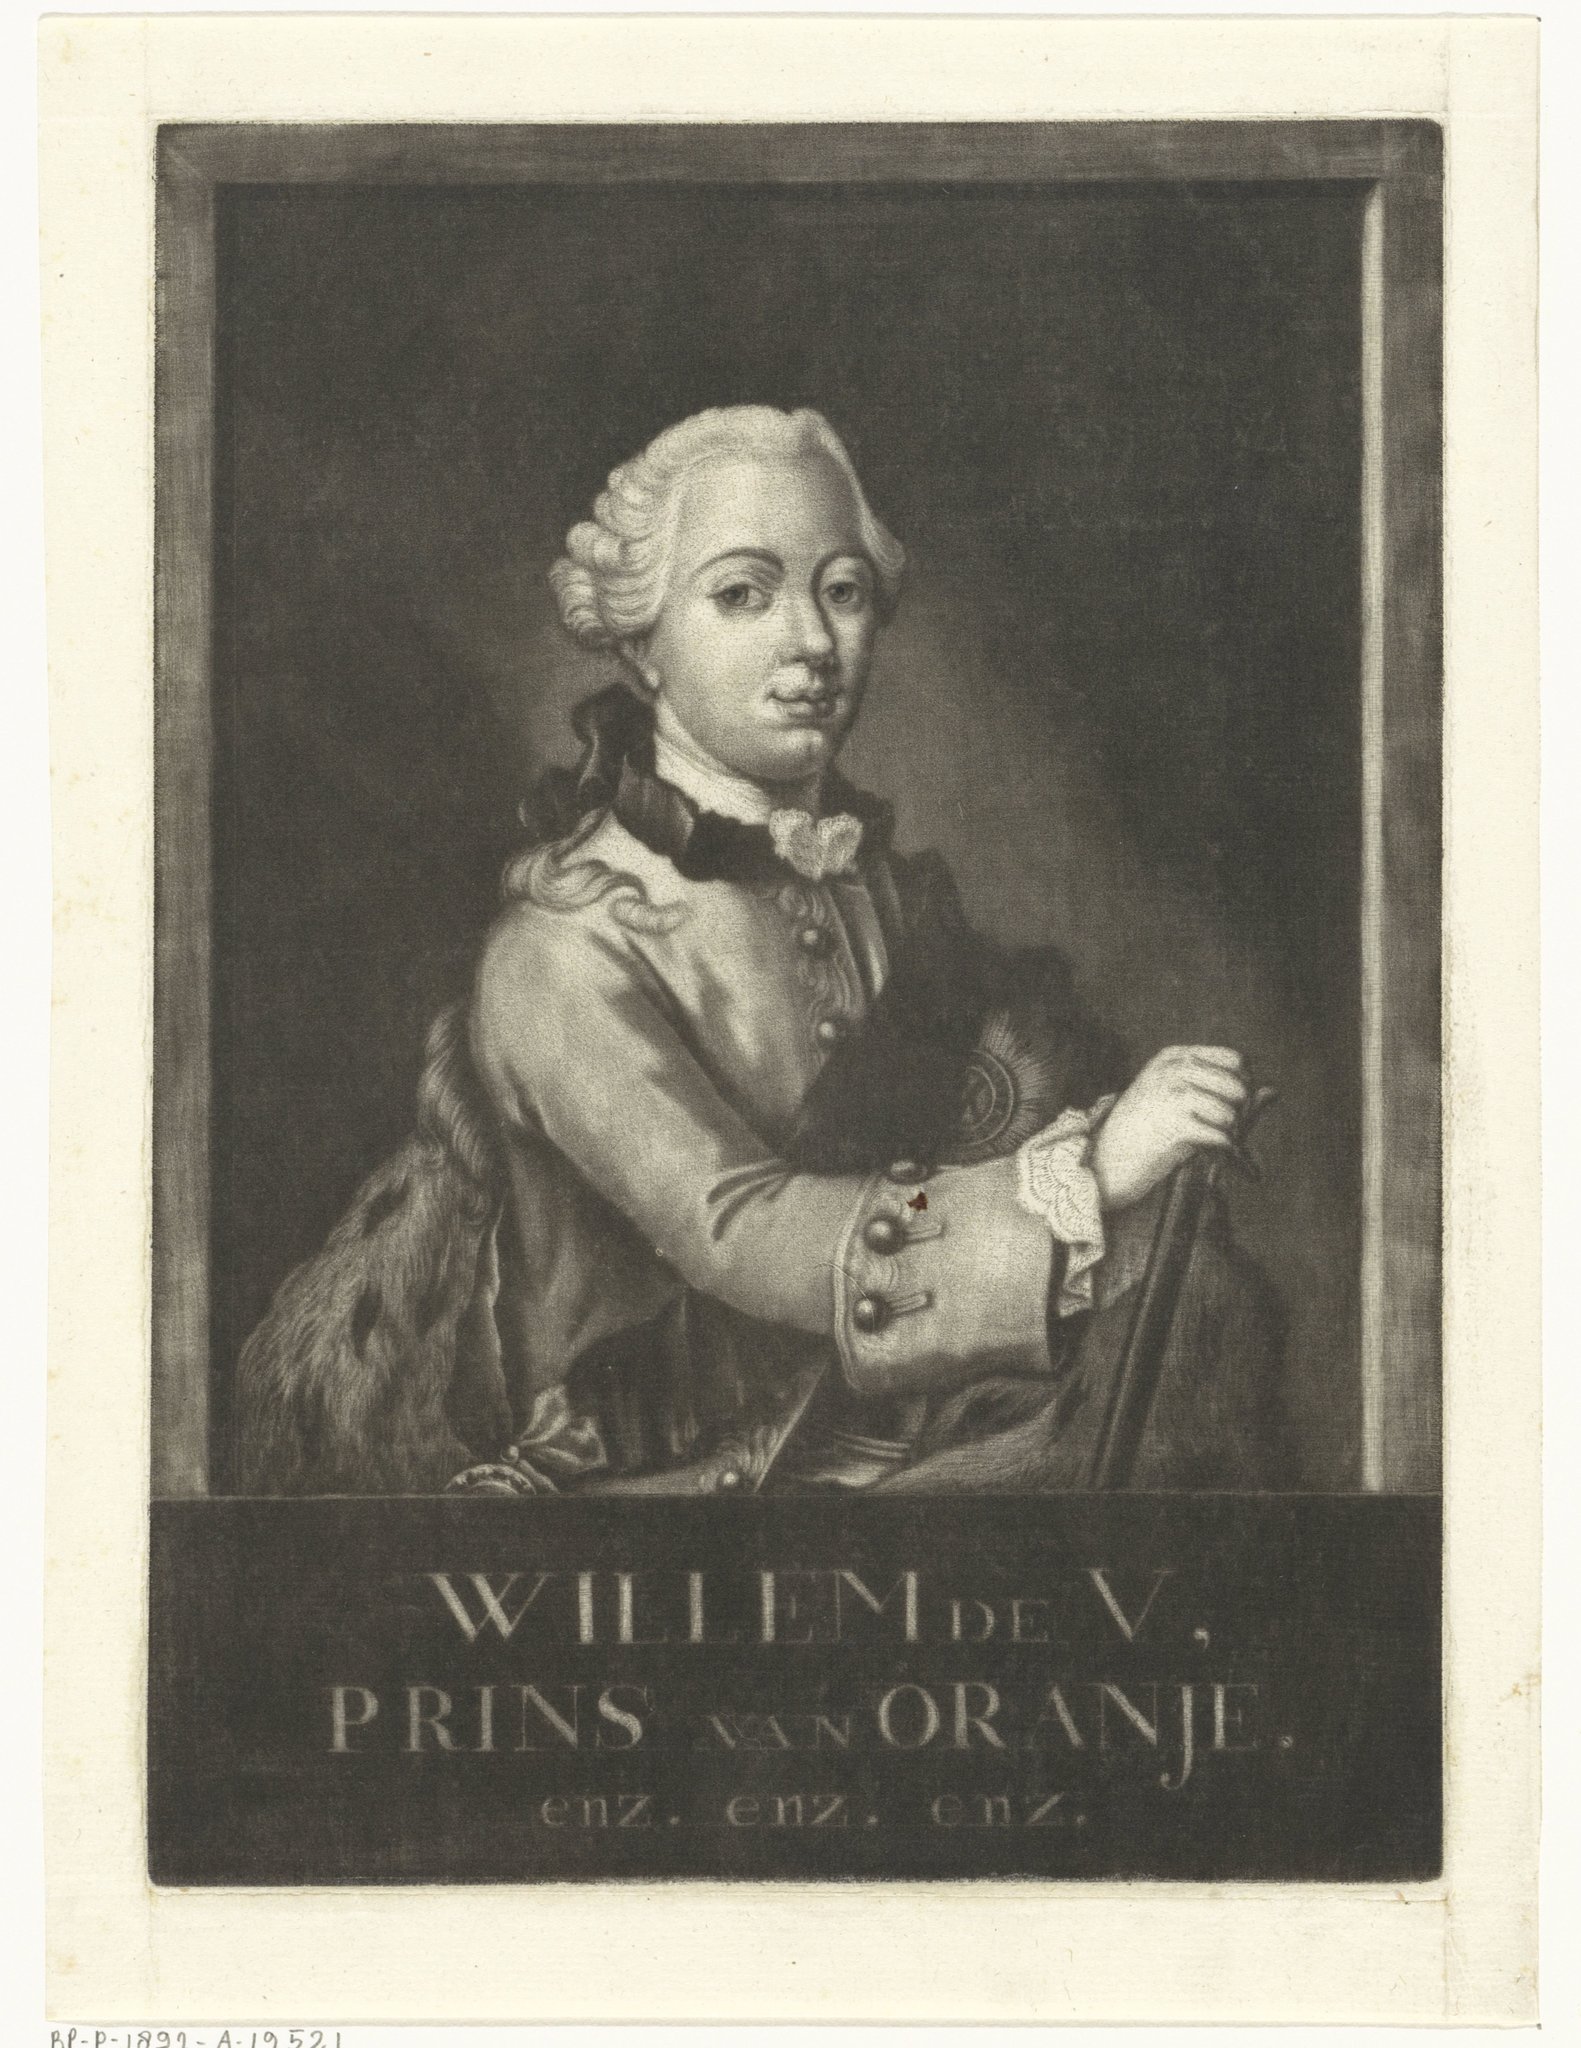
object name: print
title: Portret van Willem V, prins van Oranje en Nassau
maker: rienk jelgerhuis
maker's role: draughtsman, print maker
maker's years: 1729-1806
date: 1770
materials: paper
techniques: mezzotint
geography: leeuwarden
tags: william v (prince of orange)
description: Ook gebruikt als illustratie in: Bosch, Johannes van den. De heeren stadhouderen van Vriesland, zedert den jare acht-hondert. Leeuwarden: Abraham Ferwerda en G.Tresling, 1770.